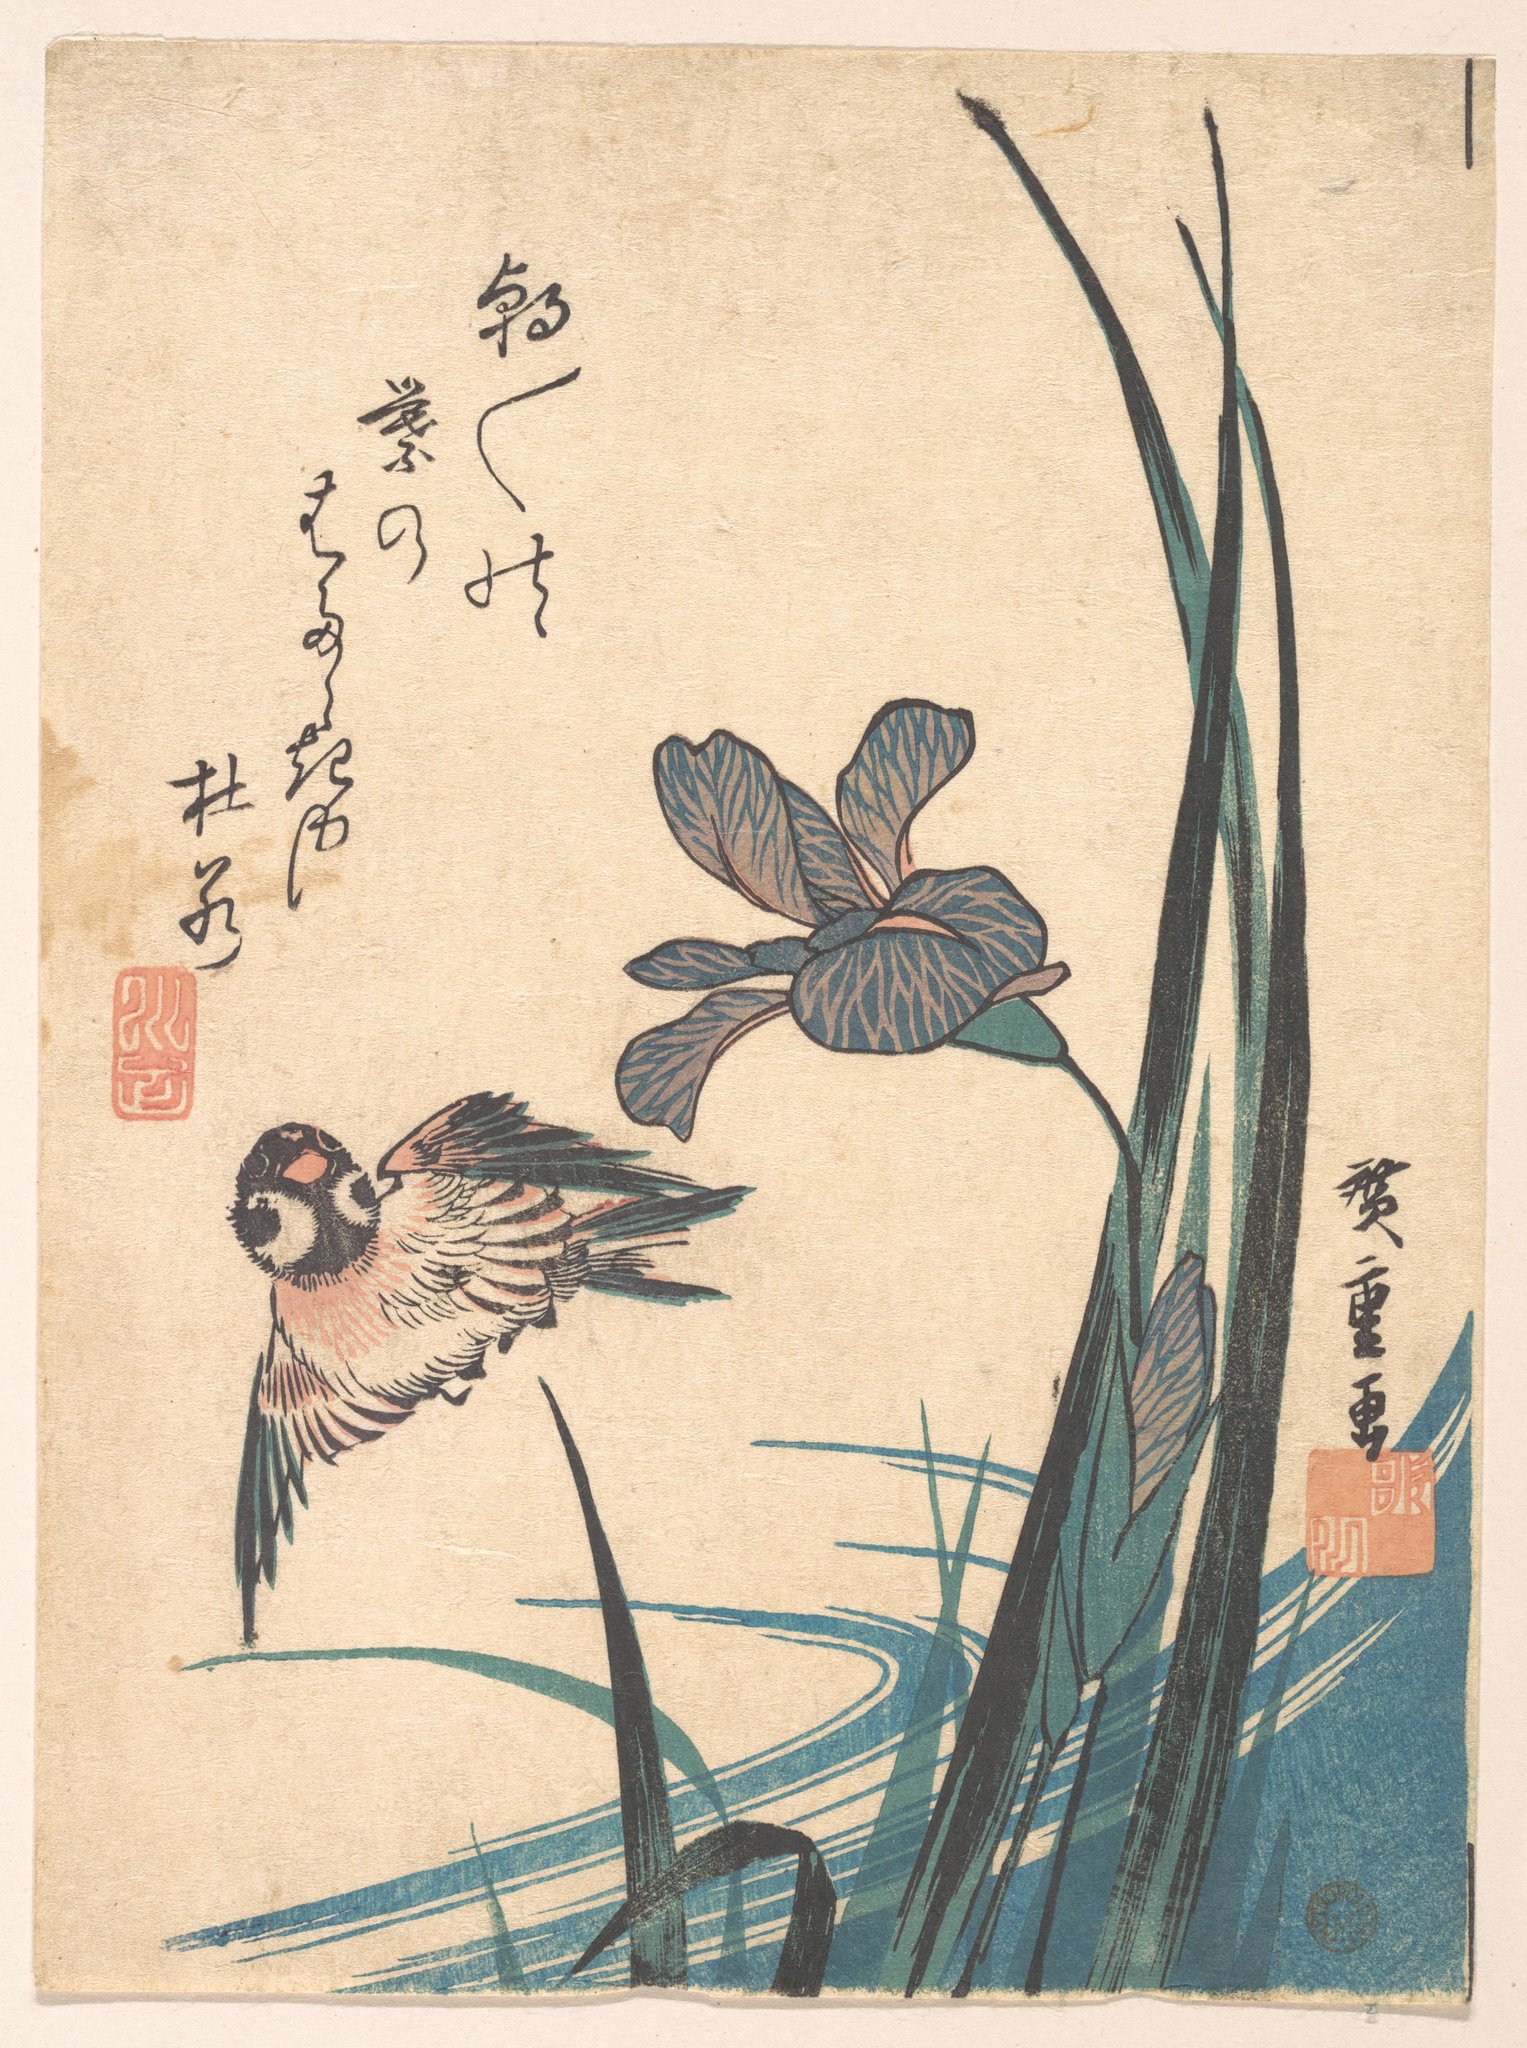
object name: print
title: Iris and Sparrow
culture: japanese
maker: utagawa hiroshige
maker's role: artist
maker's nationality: japanese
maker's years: 1797-1858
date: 1832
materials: ink, paper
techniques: woodblock print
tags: birds,flowers